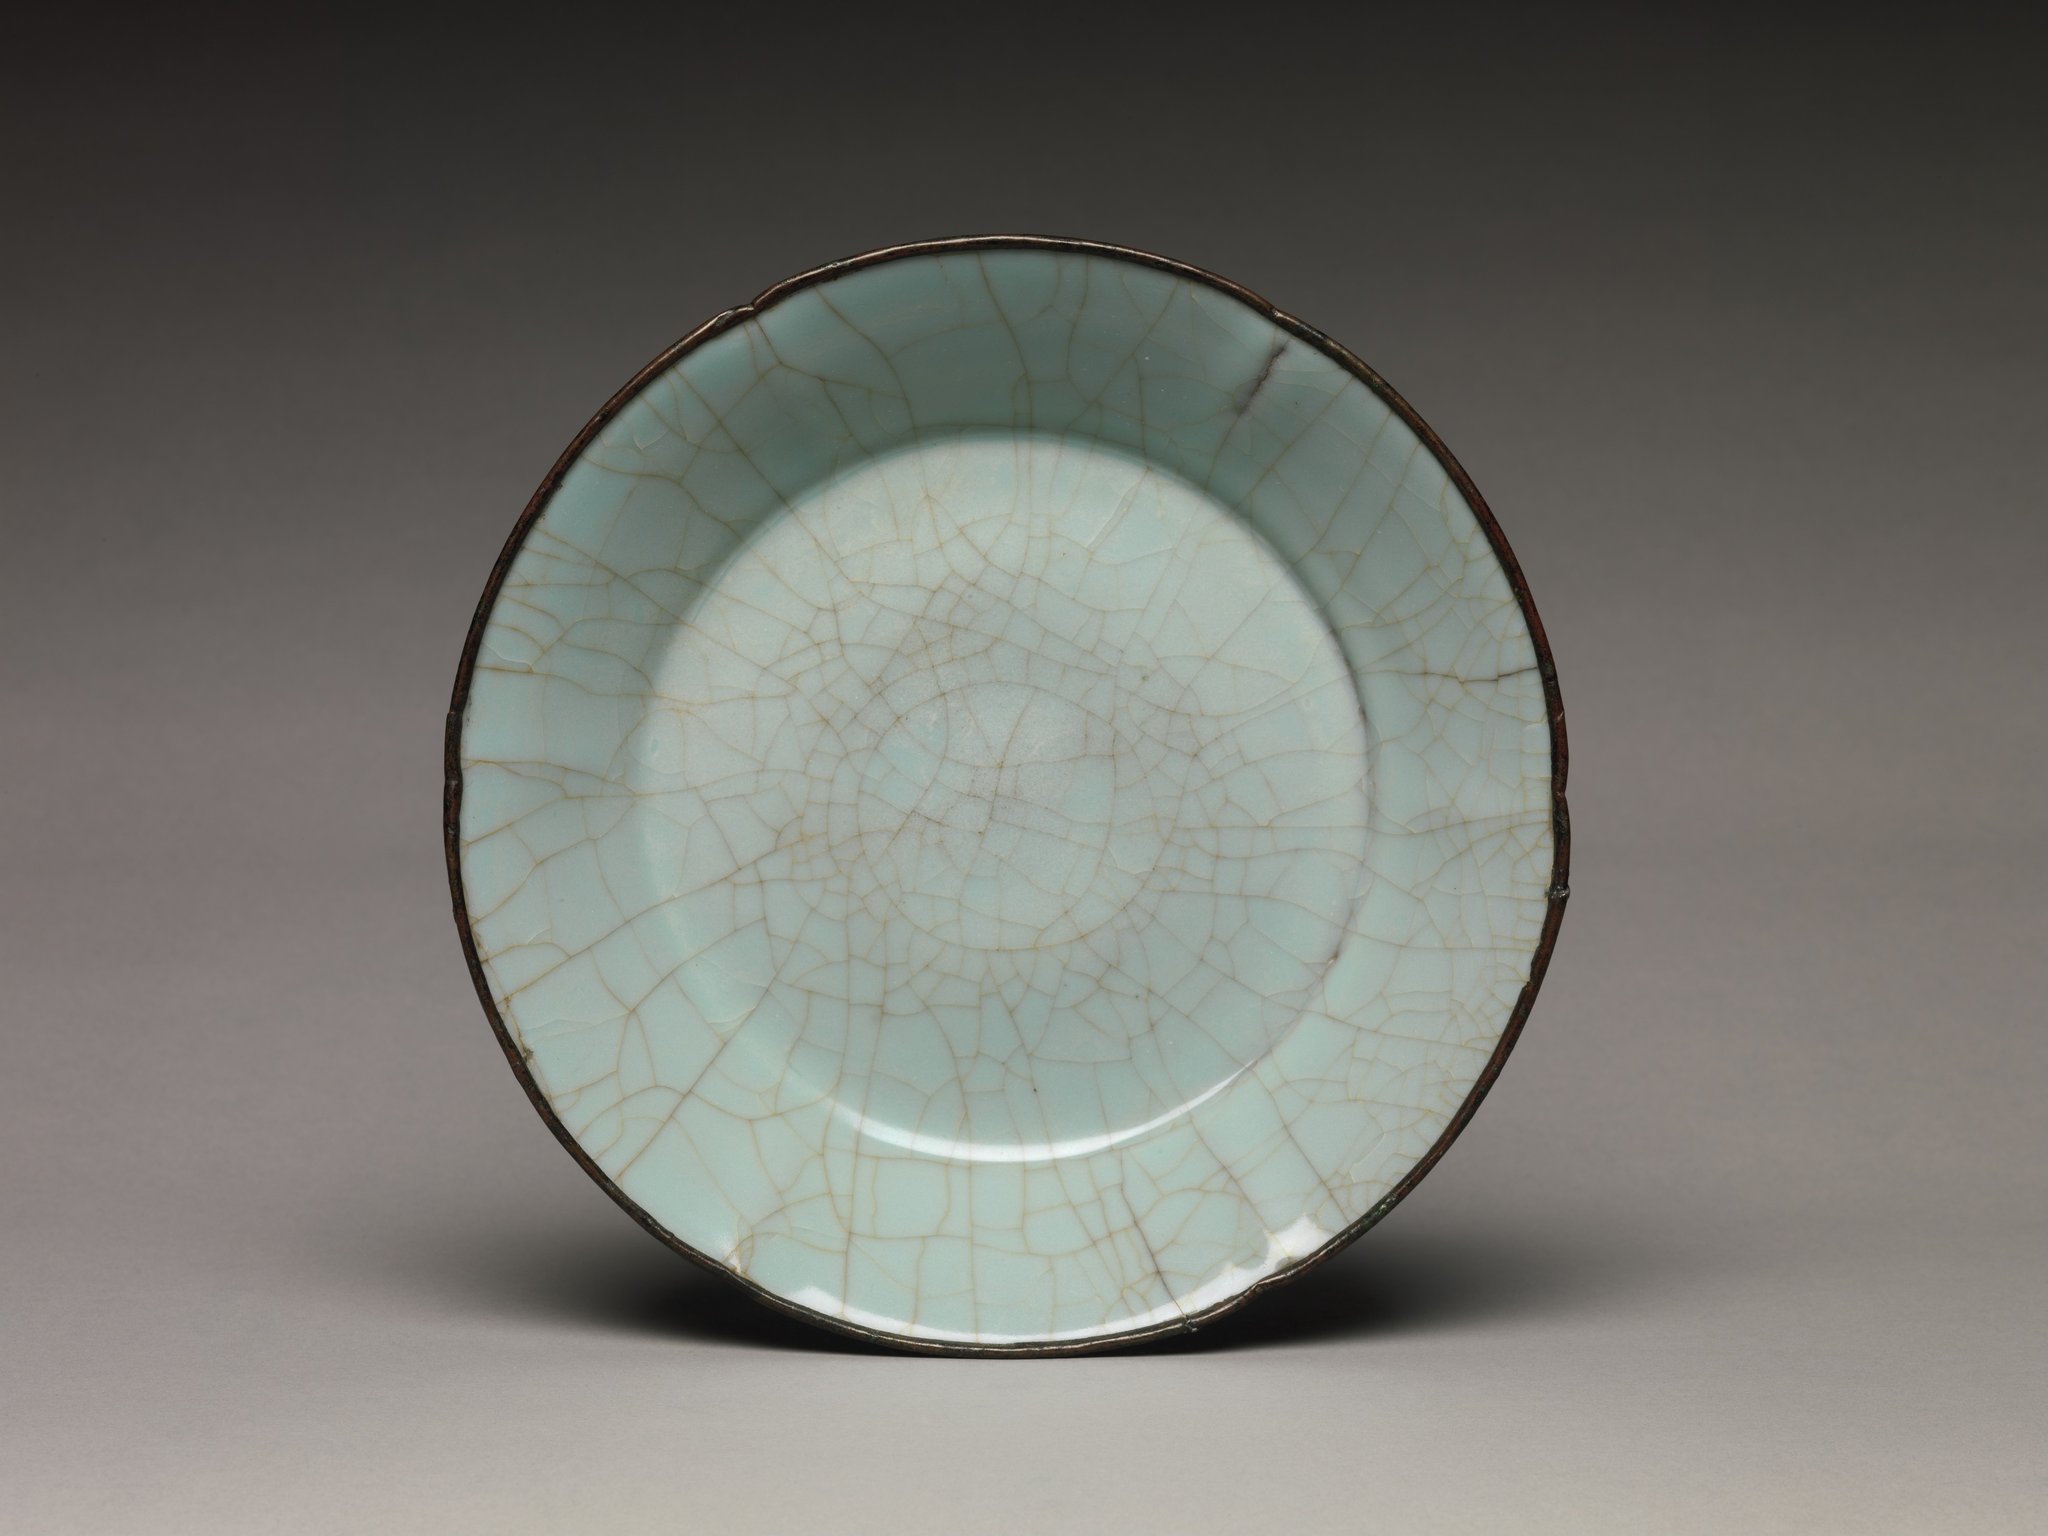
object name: dish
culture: chinese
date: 1167-1300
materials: glaze, stoneware